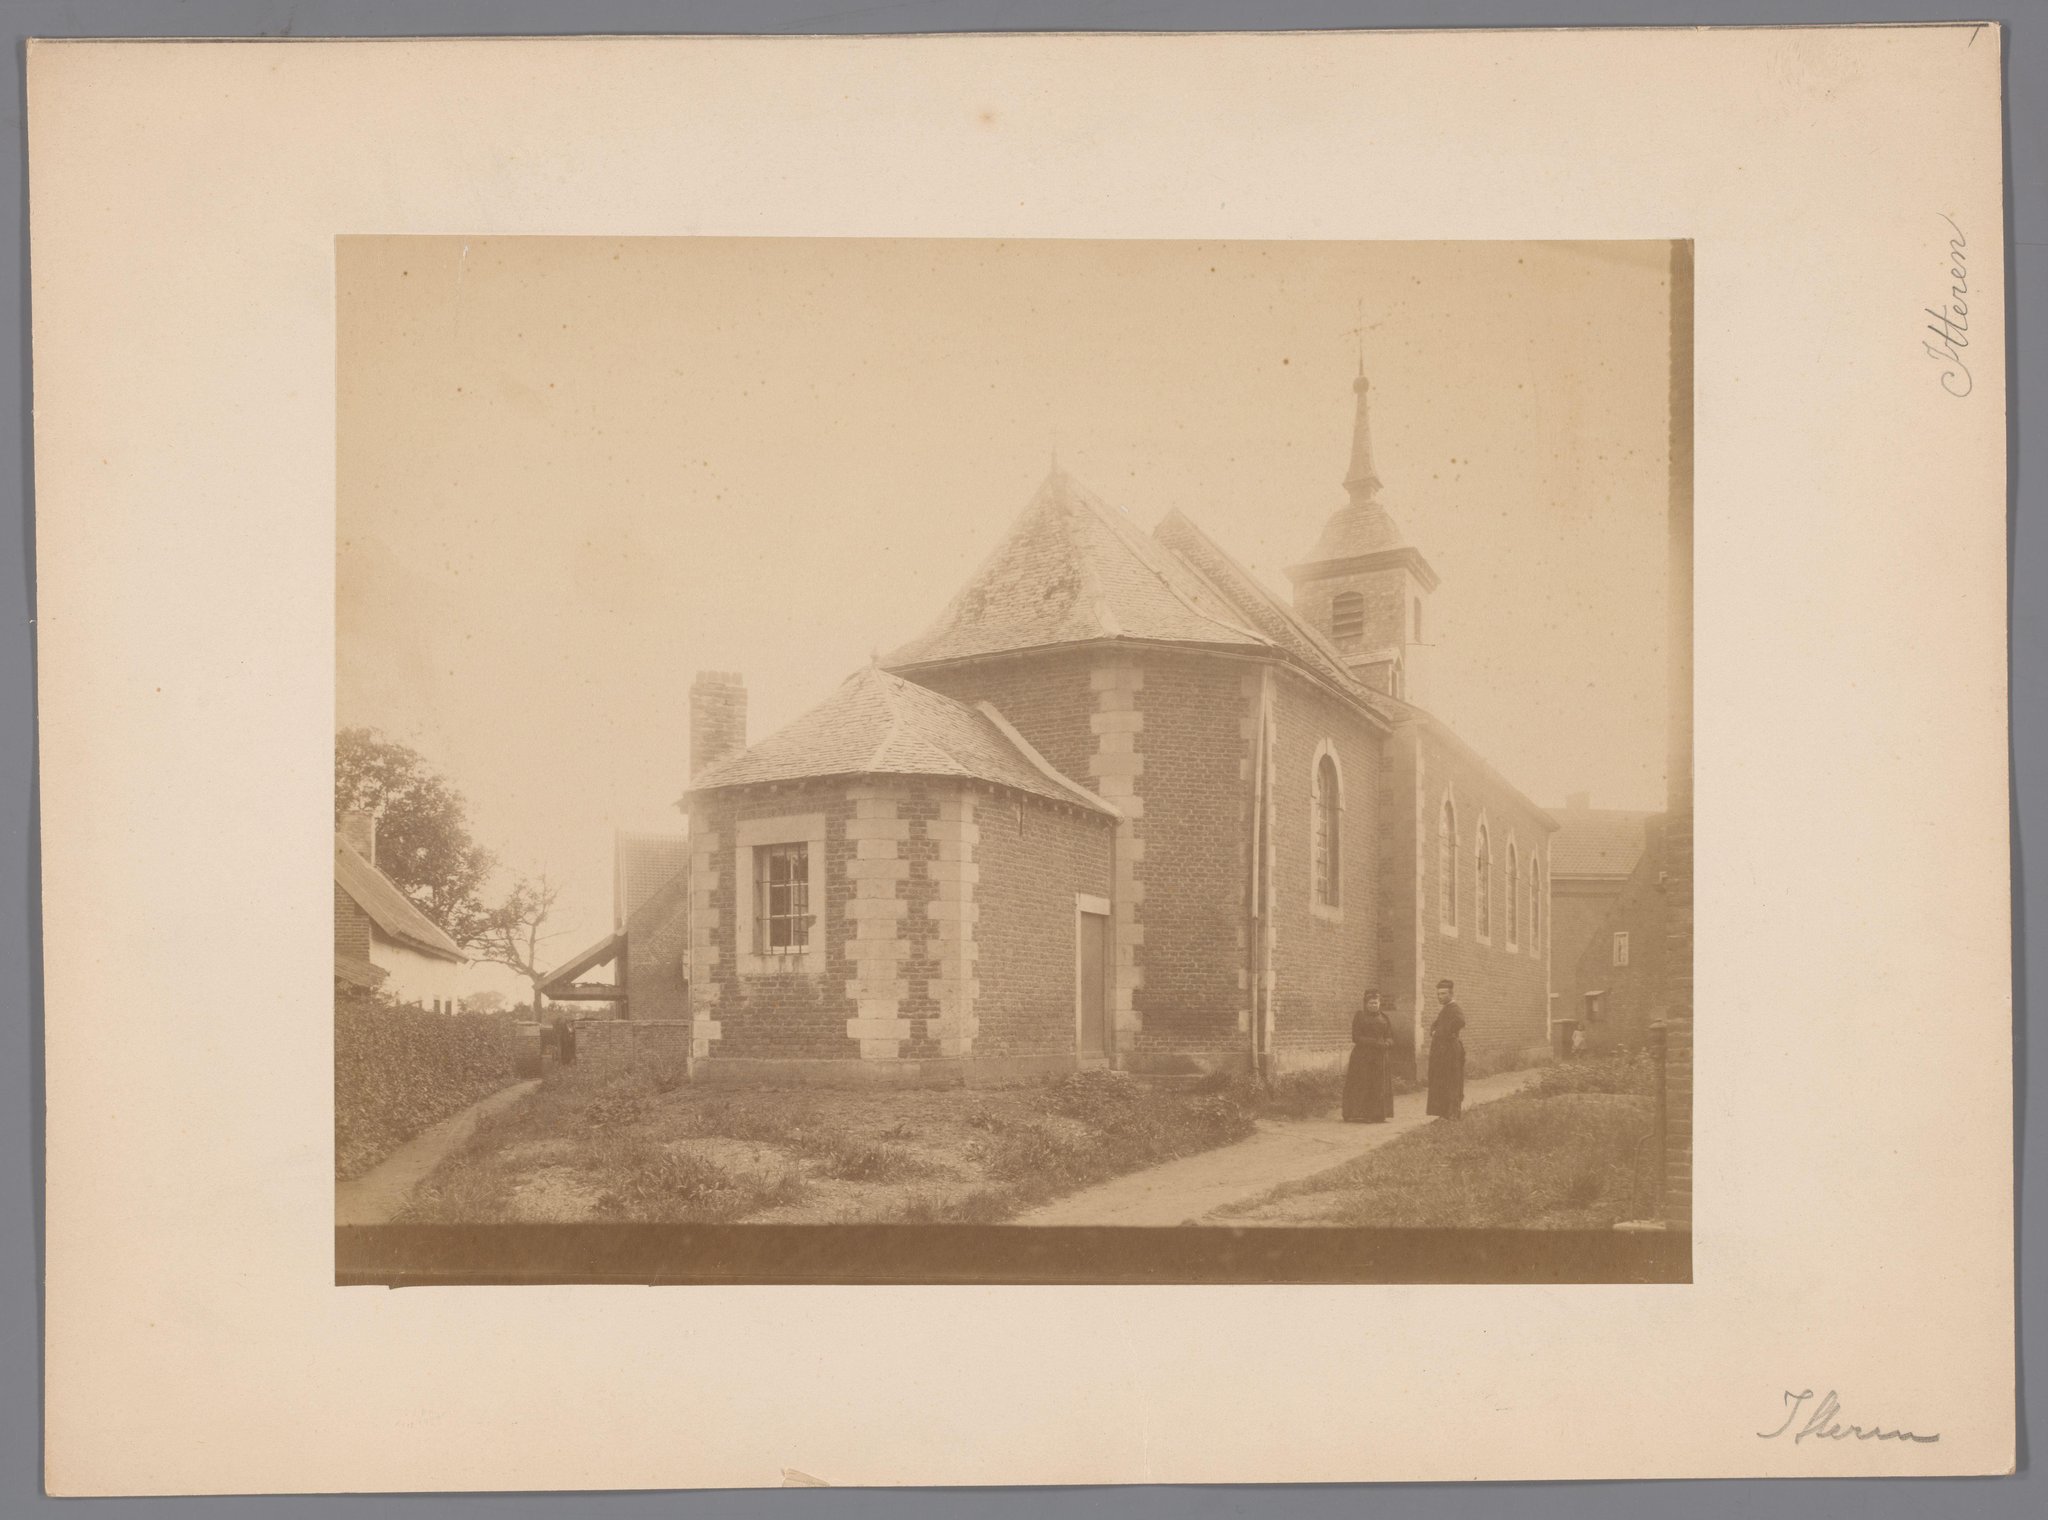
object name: photograph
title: Sint-Martinuskerk te Itteren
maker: anoniem (monumentenzorg)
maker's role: fotograaf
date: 1893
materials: cardboard, photographic support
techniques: albumen print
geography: itteren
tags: church (exterior)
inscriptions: annotation: ‘R.K. Kerk te Itteren bij Maastricht/ In Mei 1893 voor de vergrooting’, annotation: ‘Itteren/ Itteren’